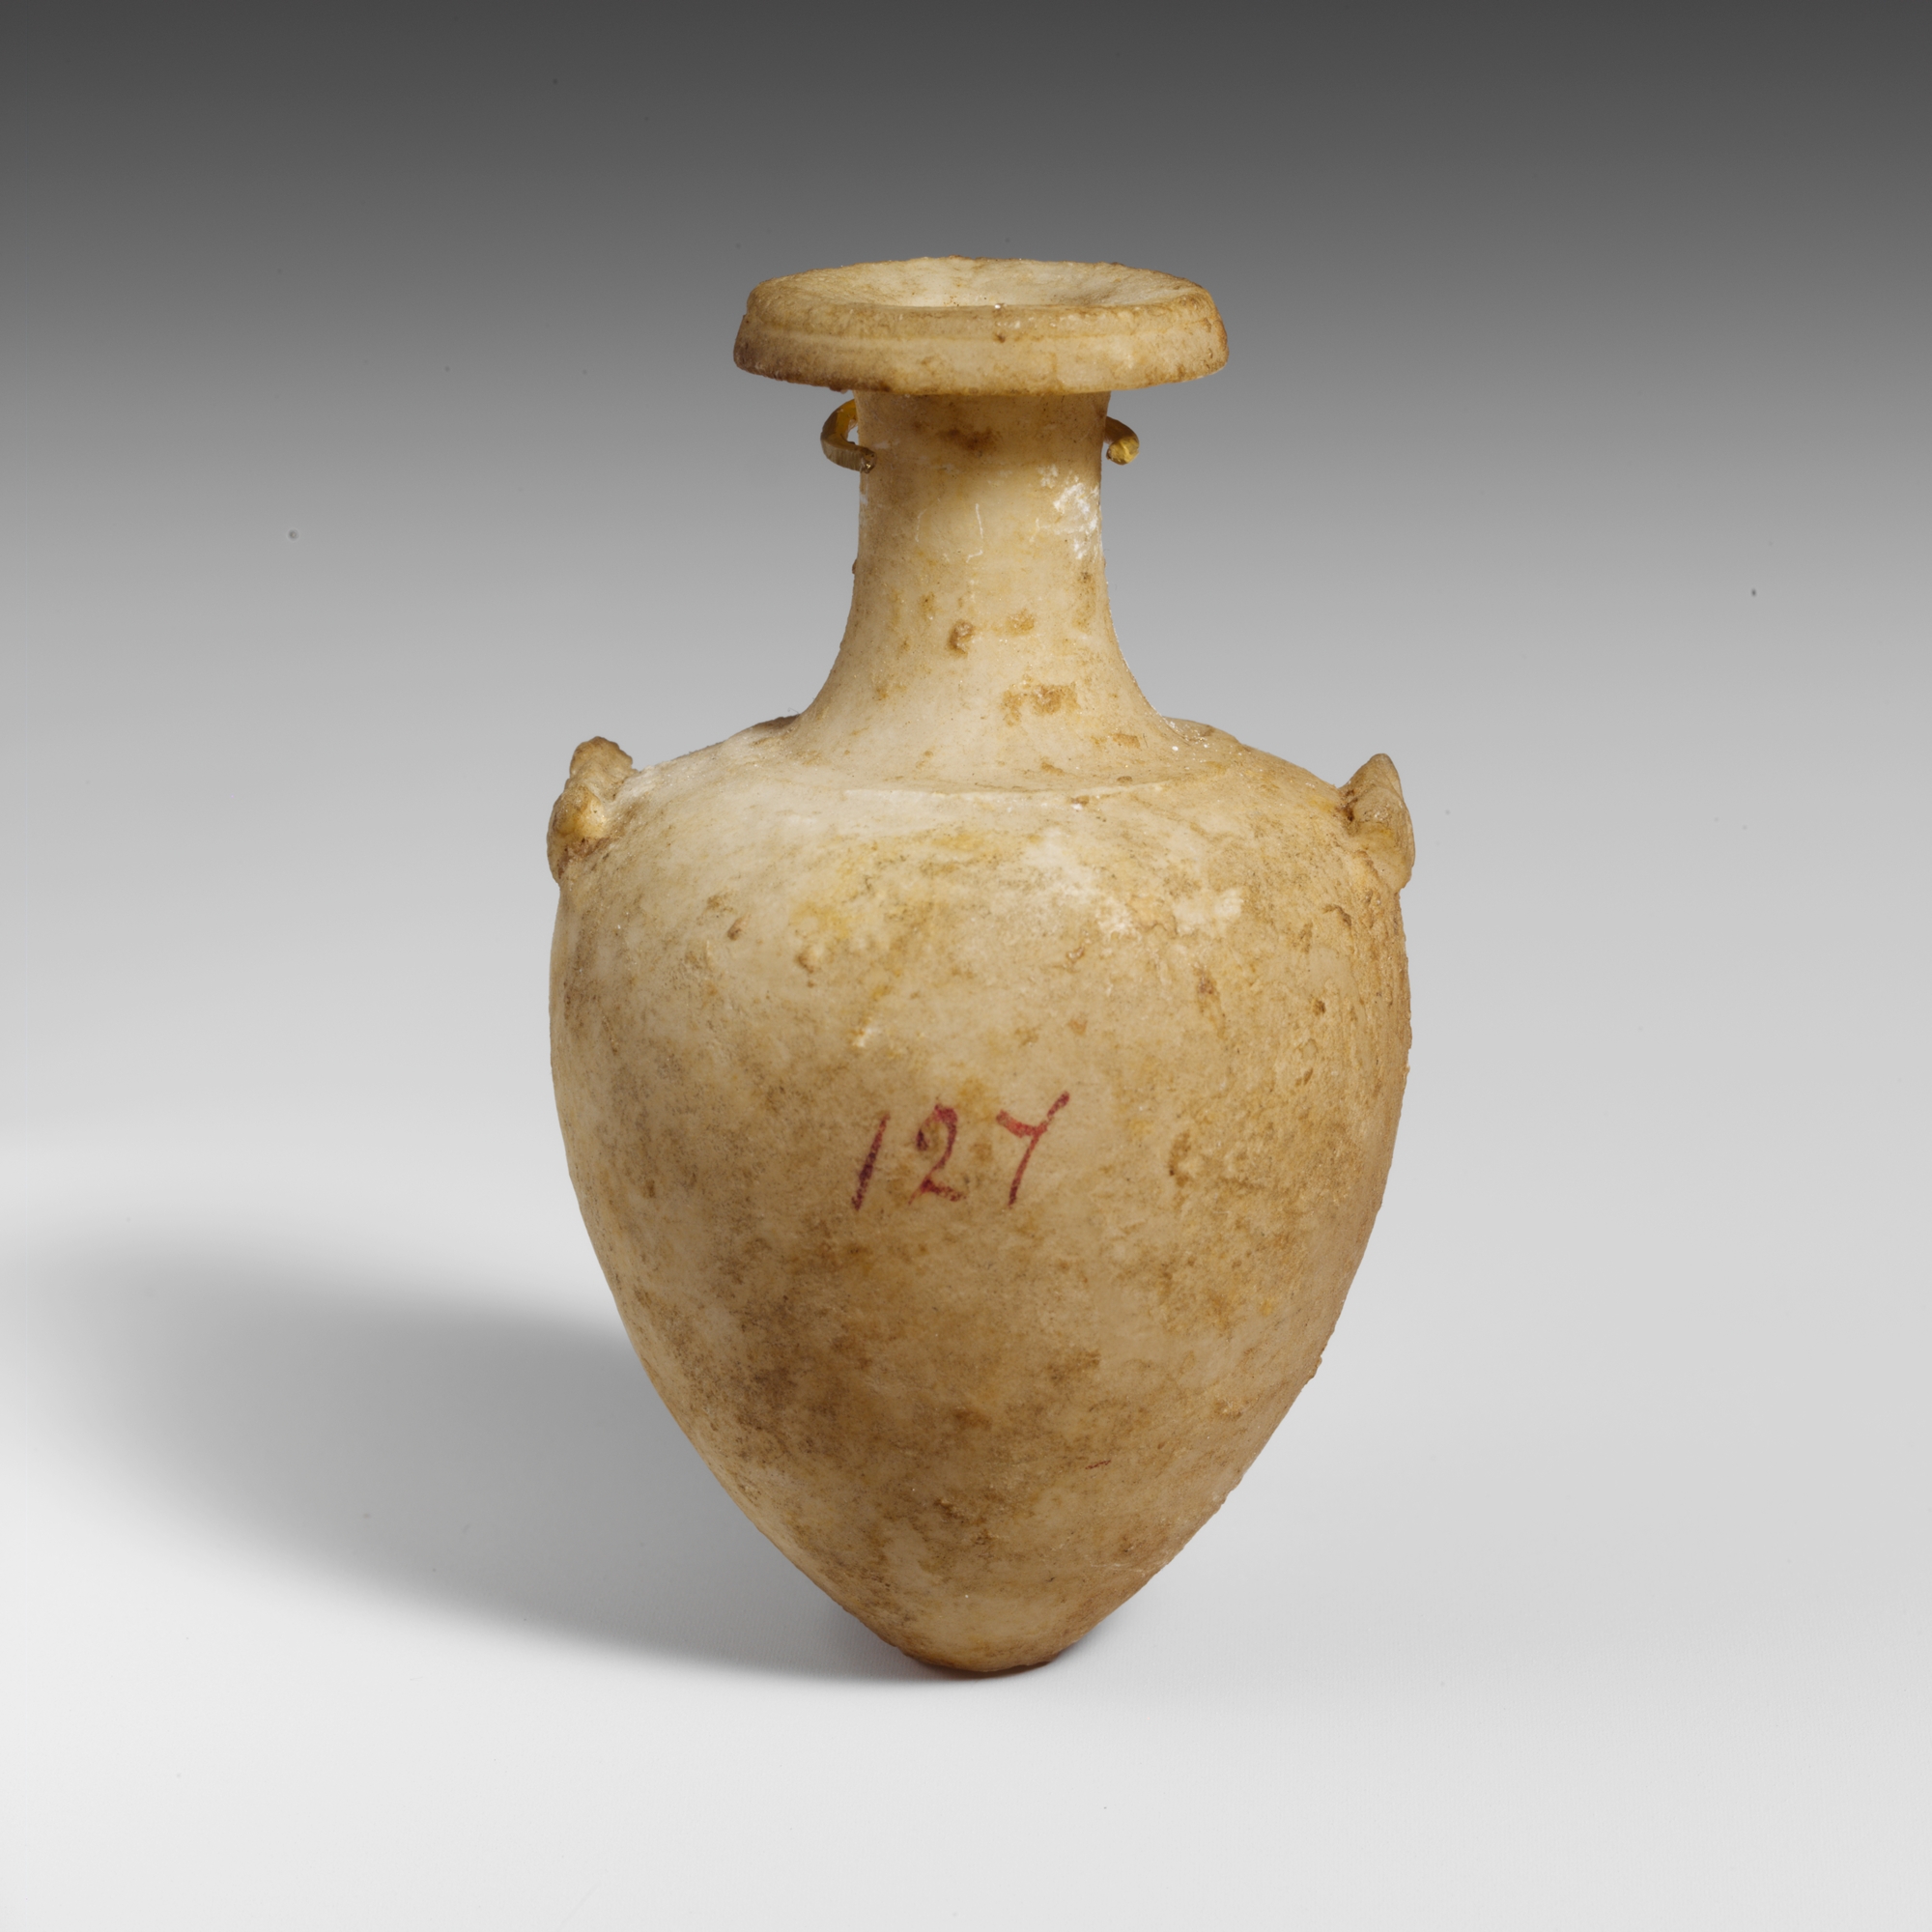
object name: vase, pear shaped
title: Miniature alabaster amphora (jar)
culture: cypriot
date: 334-201 BCE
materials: alabaster